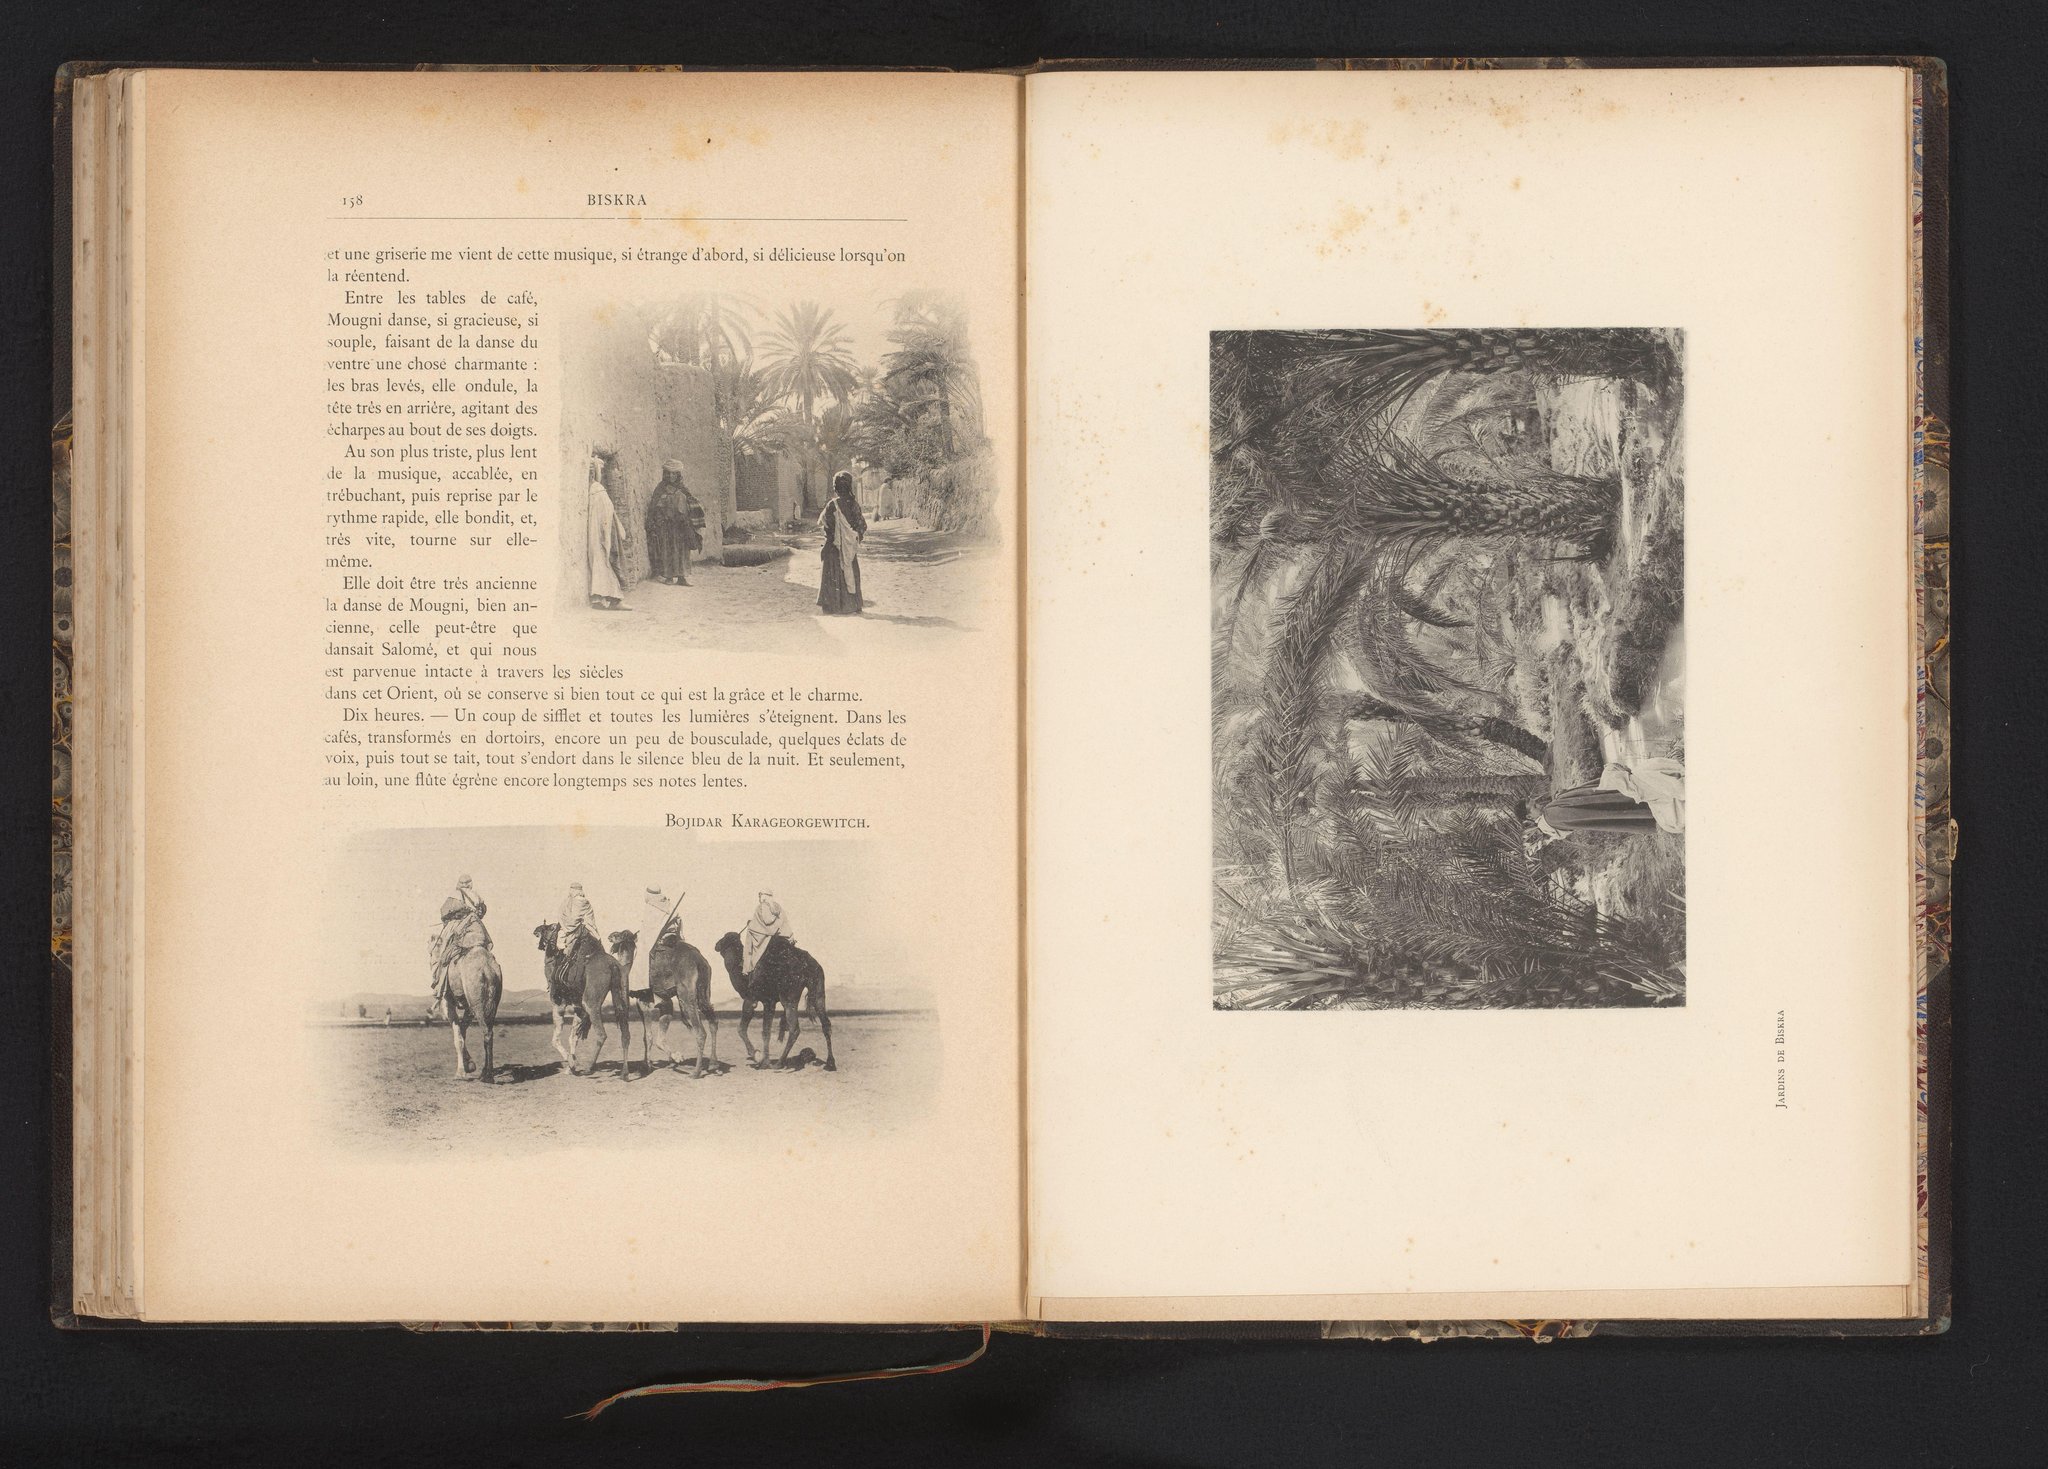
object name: page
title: Twee kinderen in de tuinen van Biskra, Algerije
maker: jules gervais-courtellemont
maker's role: fotograaf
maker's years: 1863-1931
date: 1888-1893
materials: paper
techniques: photograph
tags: garden, child